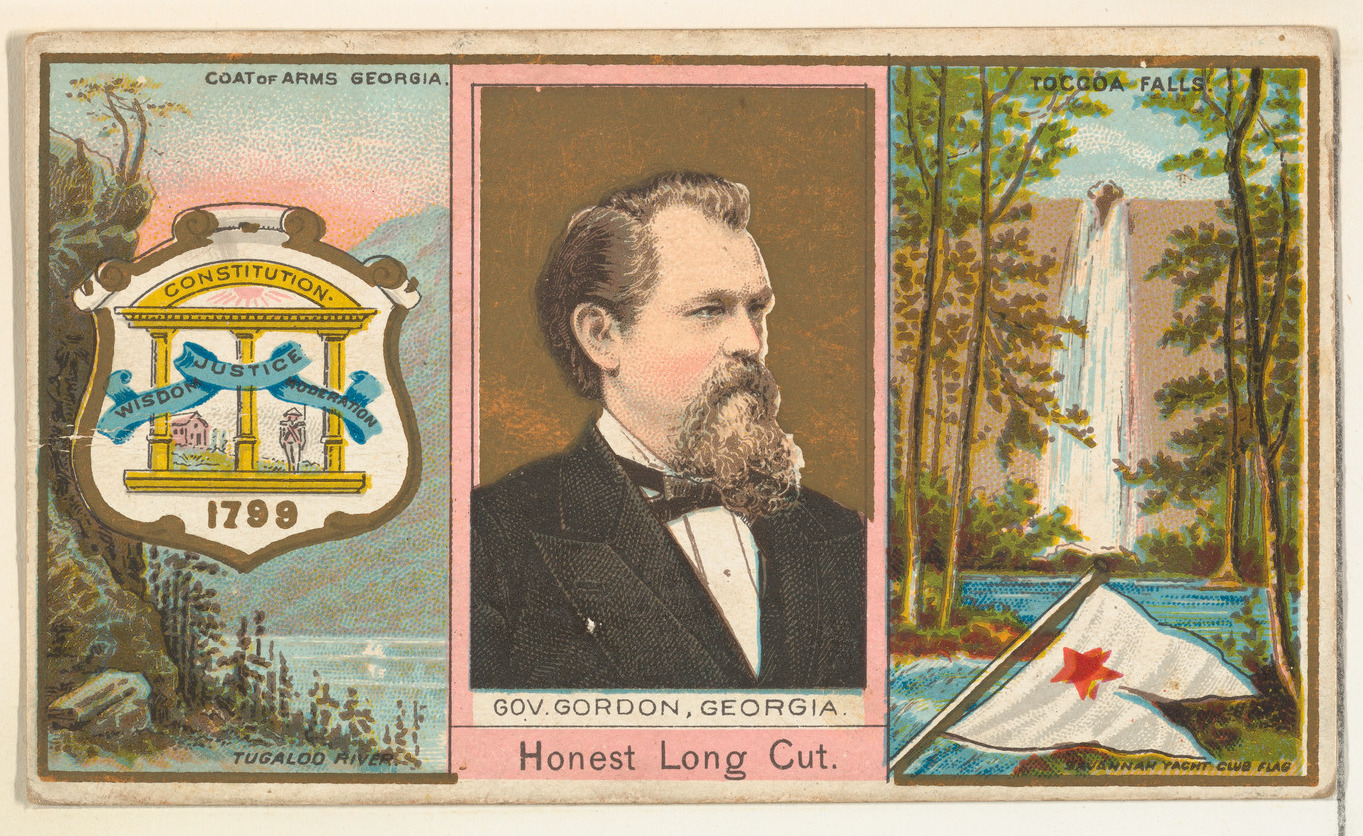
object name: print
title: Governor Gordon, Georgia, from "Governors, Arms, Etc." series (N133-1), issued by Duke Sons & Co.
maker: w. duke, sons & co.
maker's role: publisher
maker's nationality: american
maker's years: 1870-1920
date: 1888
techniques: color lithograph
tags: men,profiles,waterfalls,coat of arms,flags